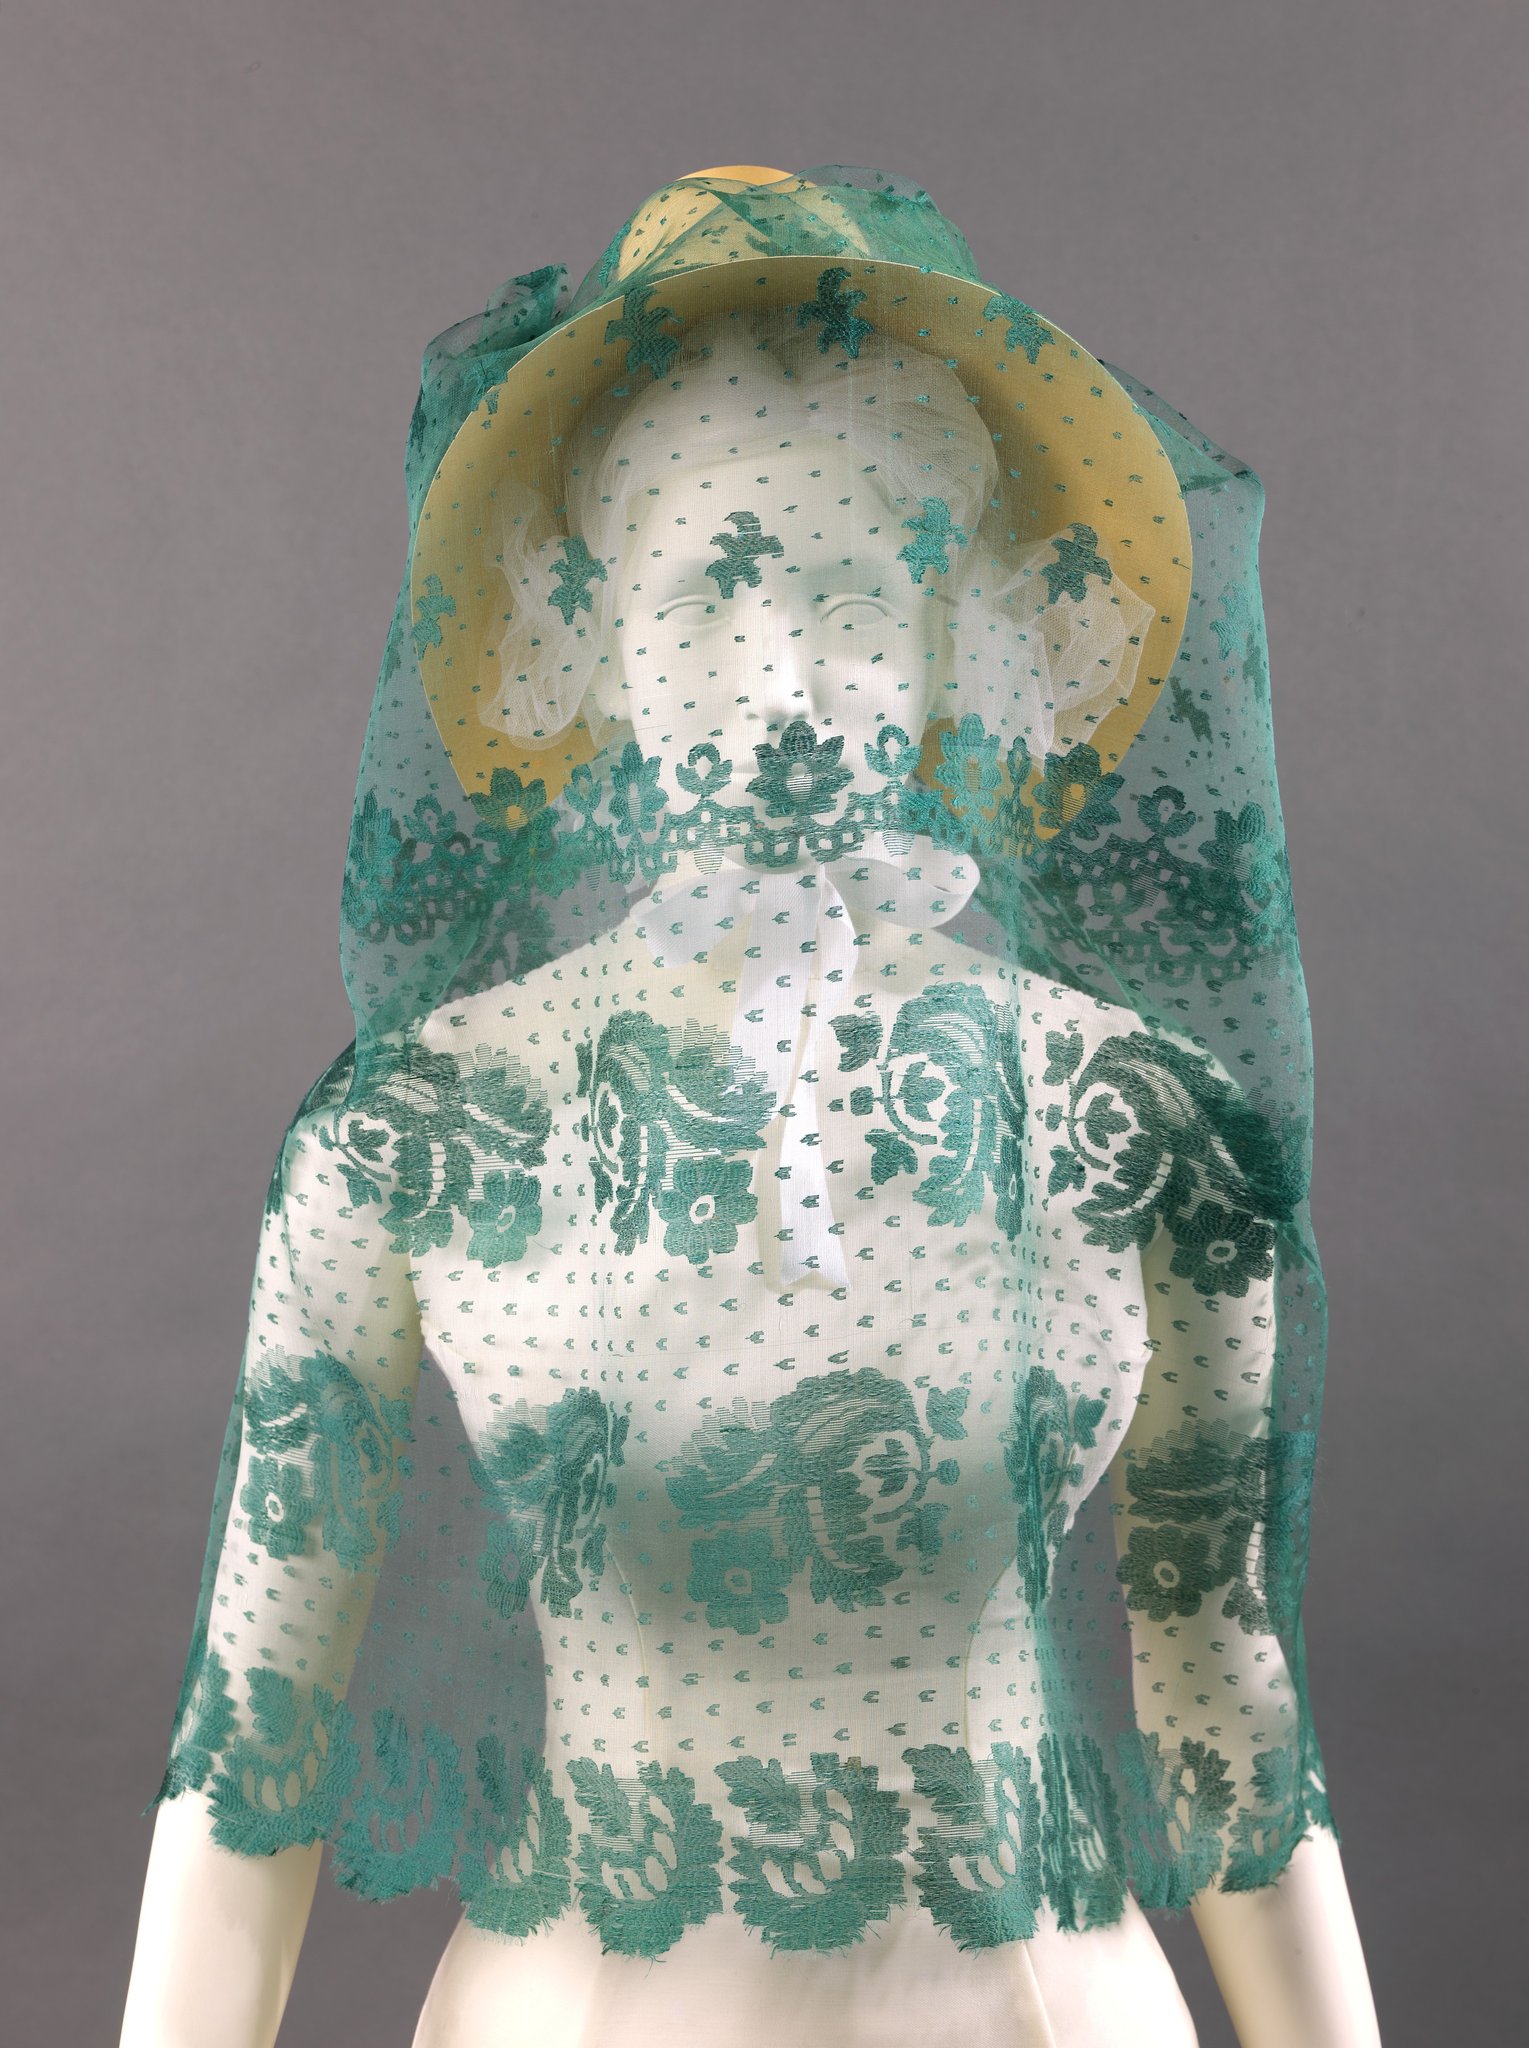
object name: veil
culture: british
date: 1835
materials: silk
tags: flowers